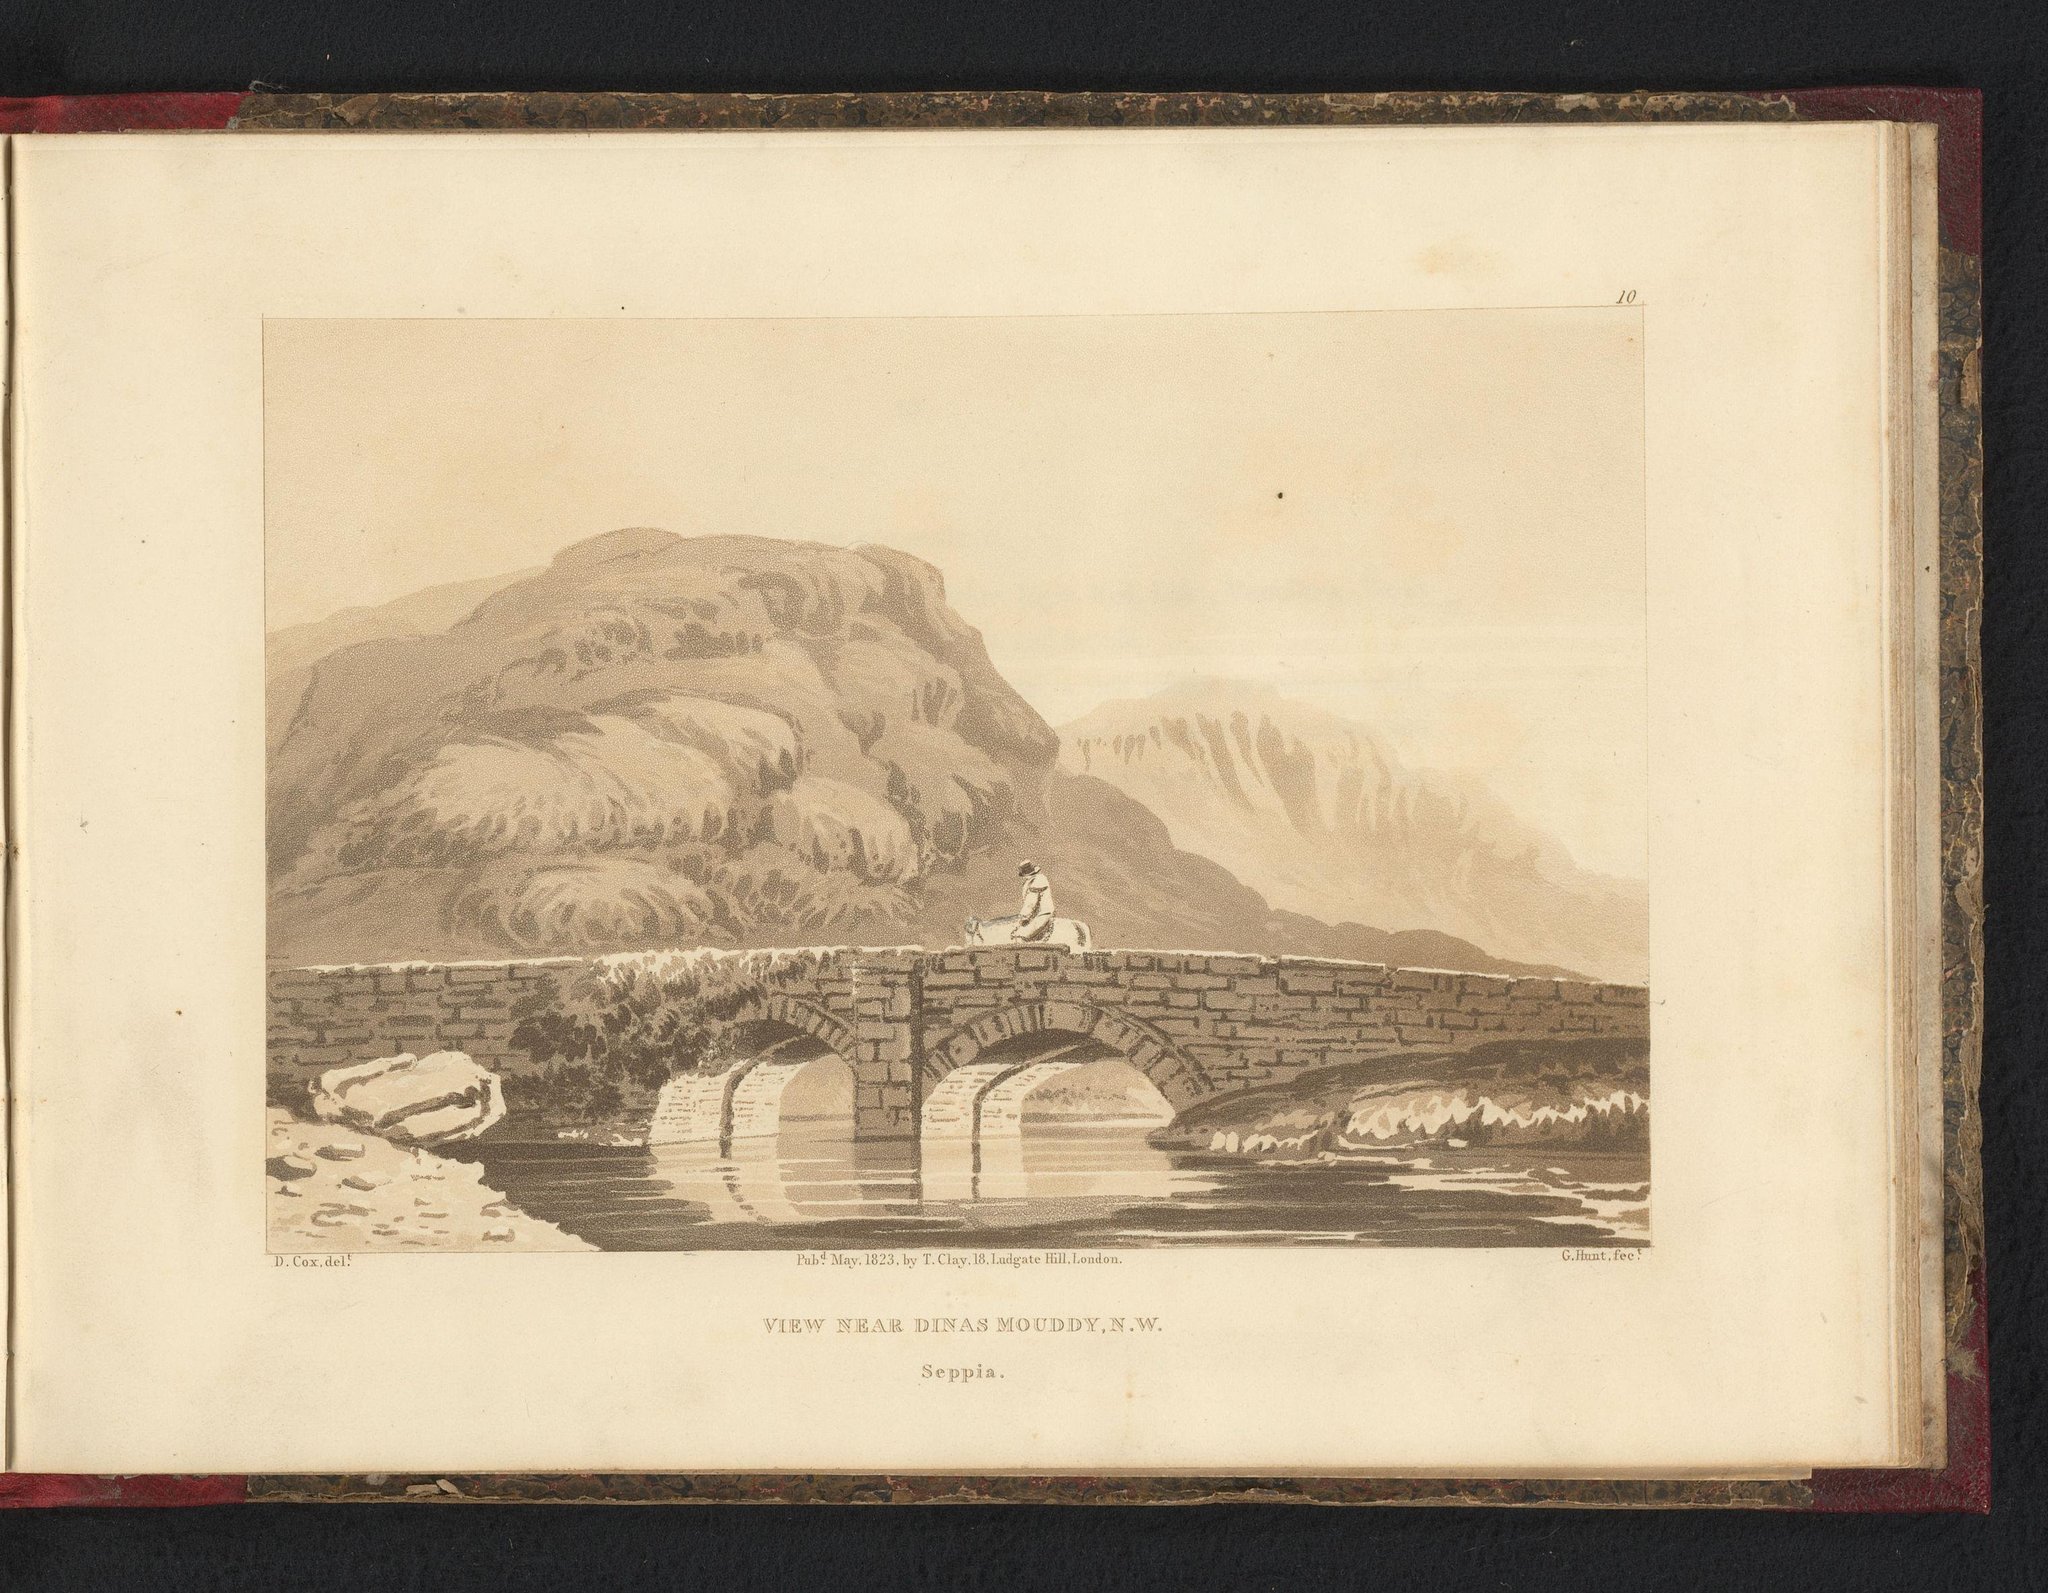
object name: page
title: Landschap met rivier nabij Dinas Mawddwy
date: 1828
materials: paper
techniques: aquatint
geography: london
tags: painting (including book-illumination, miniature-painting), river (+ landscape with figures, staffage)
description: Prent is gedrukt op de pagina tegenover pagina 18.